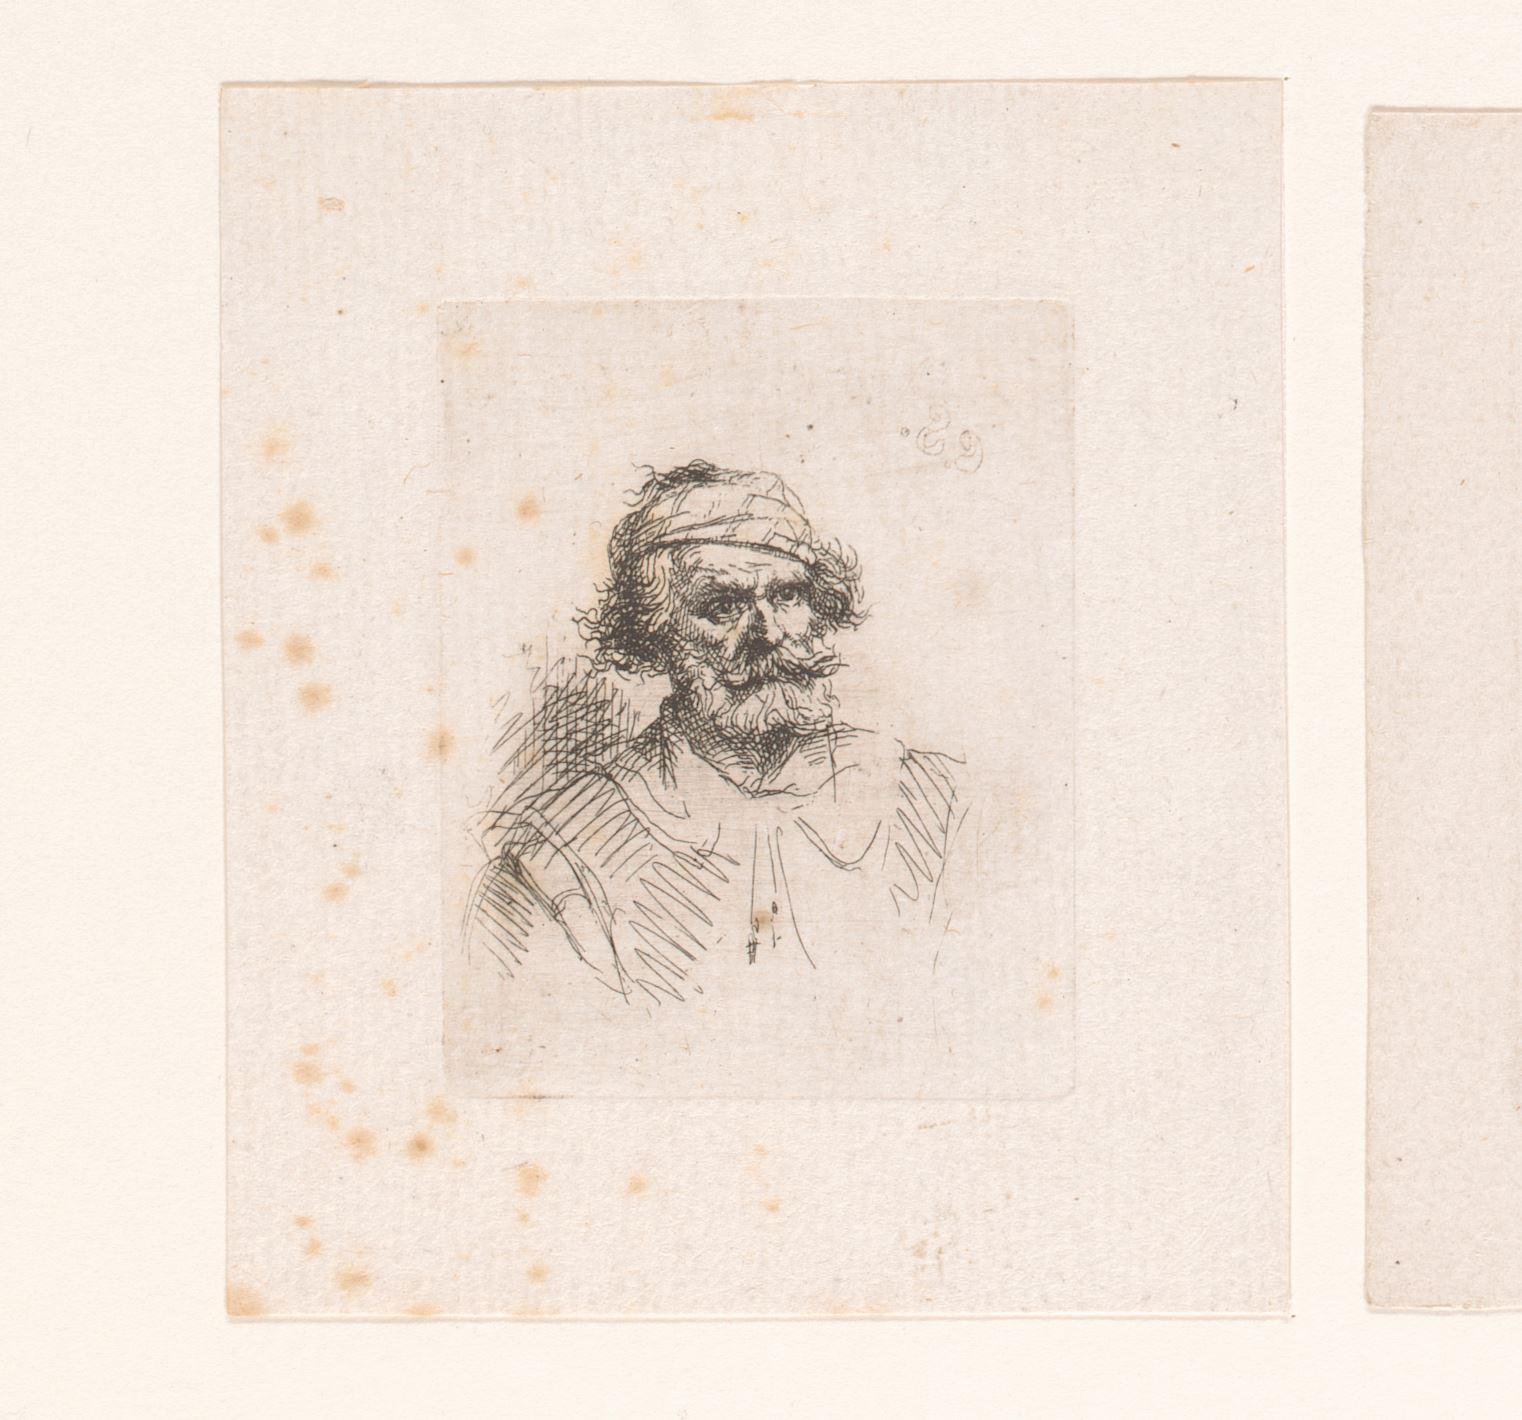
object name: print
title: Portret van een onbekende bebaarde soldaat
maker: corneille seghers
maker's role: draughtsman, print maker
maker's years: 1814-1869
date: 1824-1869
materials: paper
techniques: etching, intaglio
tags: private soldier, anonymous historical person portrayed alone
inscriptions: collector's mark: Lugt 1485, collector's mark: Lugt 2228